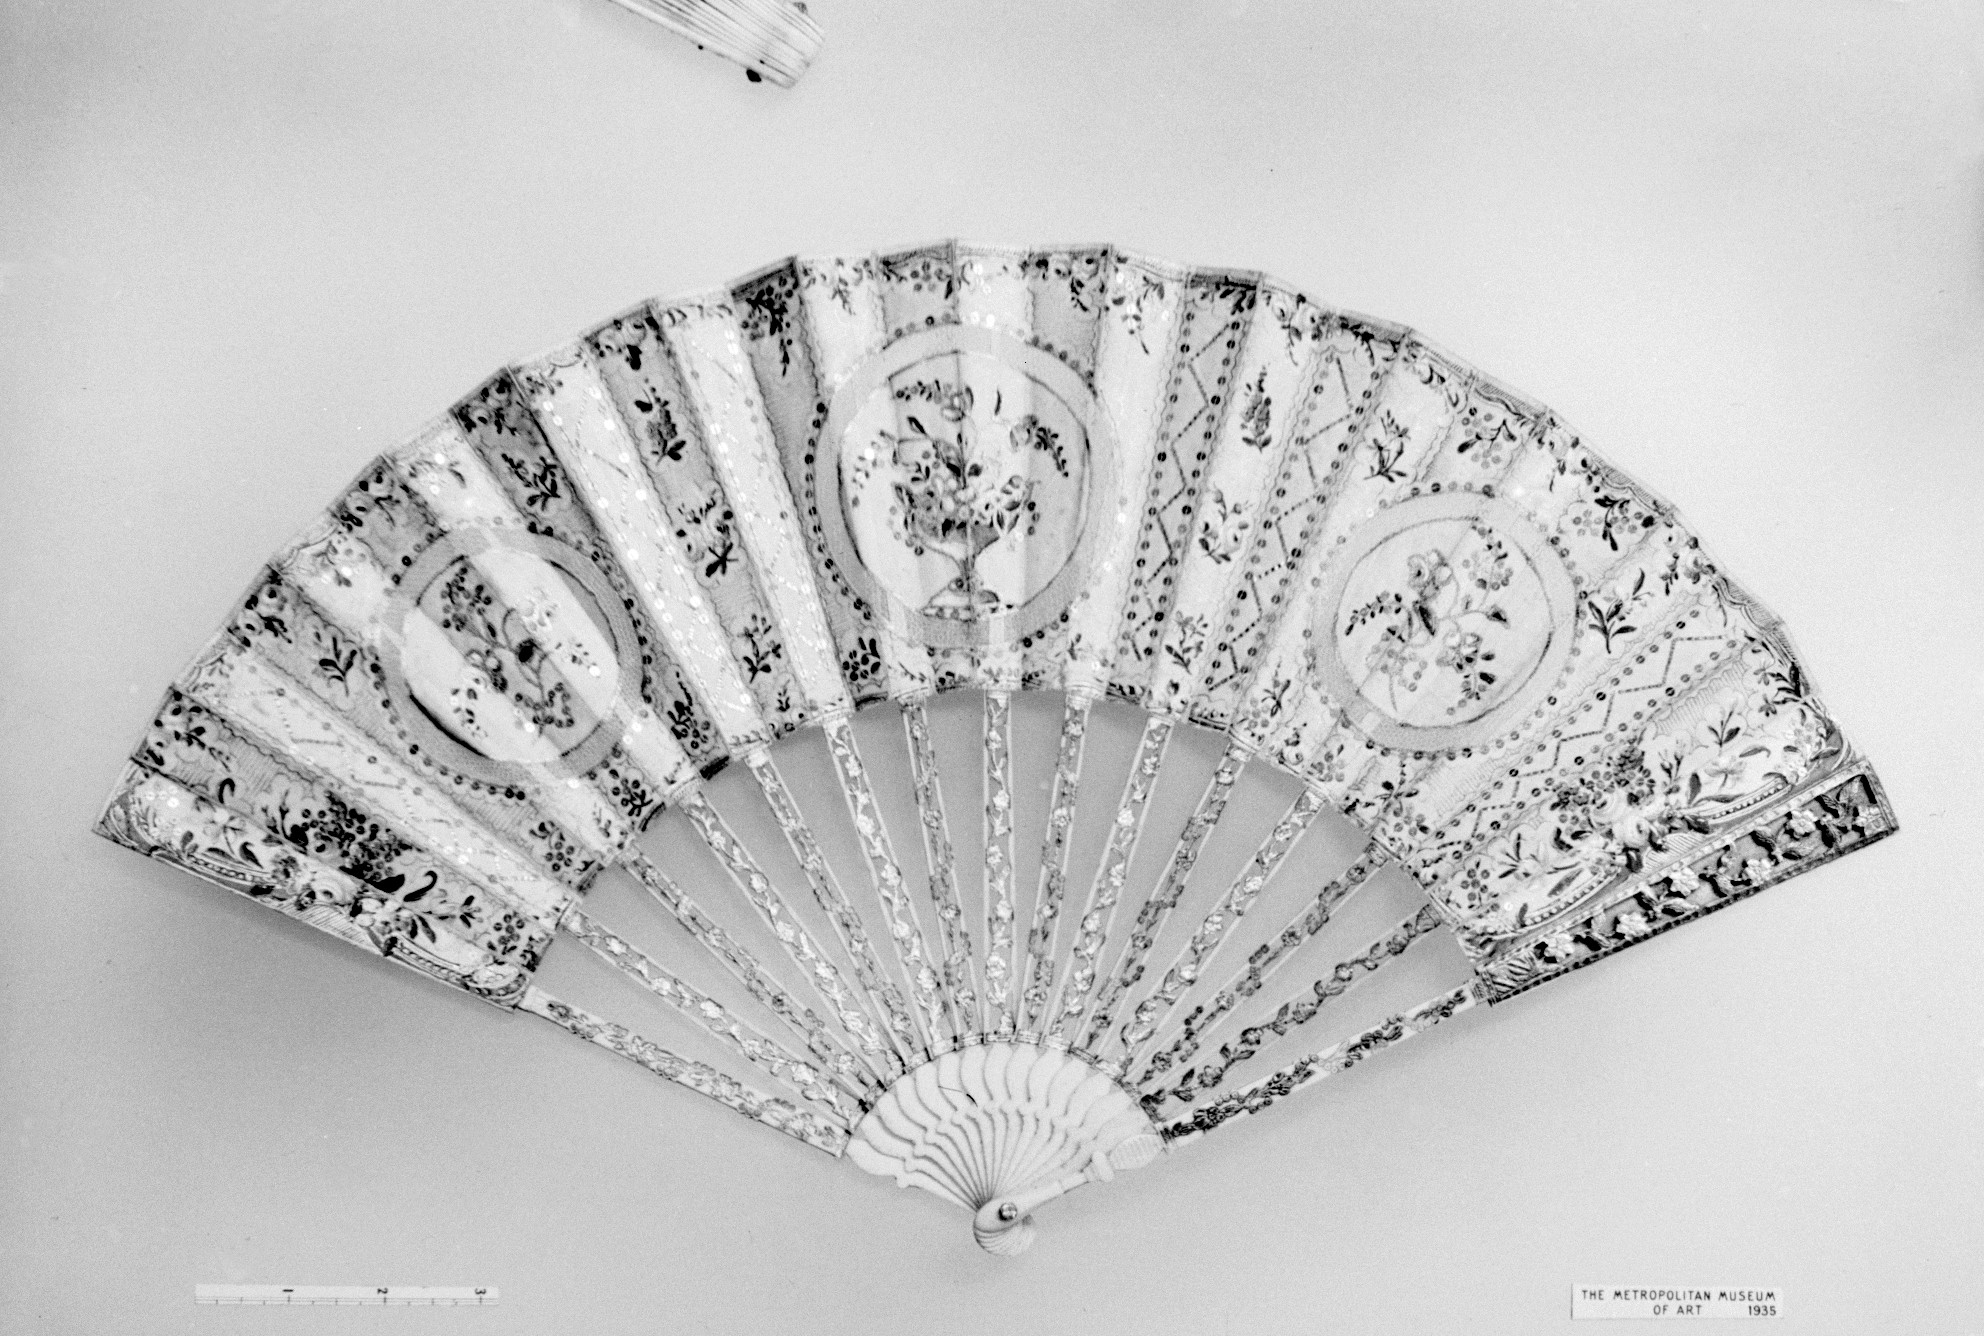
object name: fan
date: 1776-1800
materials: ivory, silk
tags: flowers